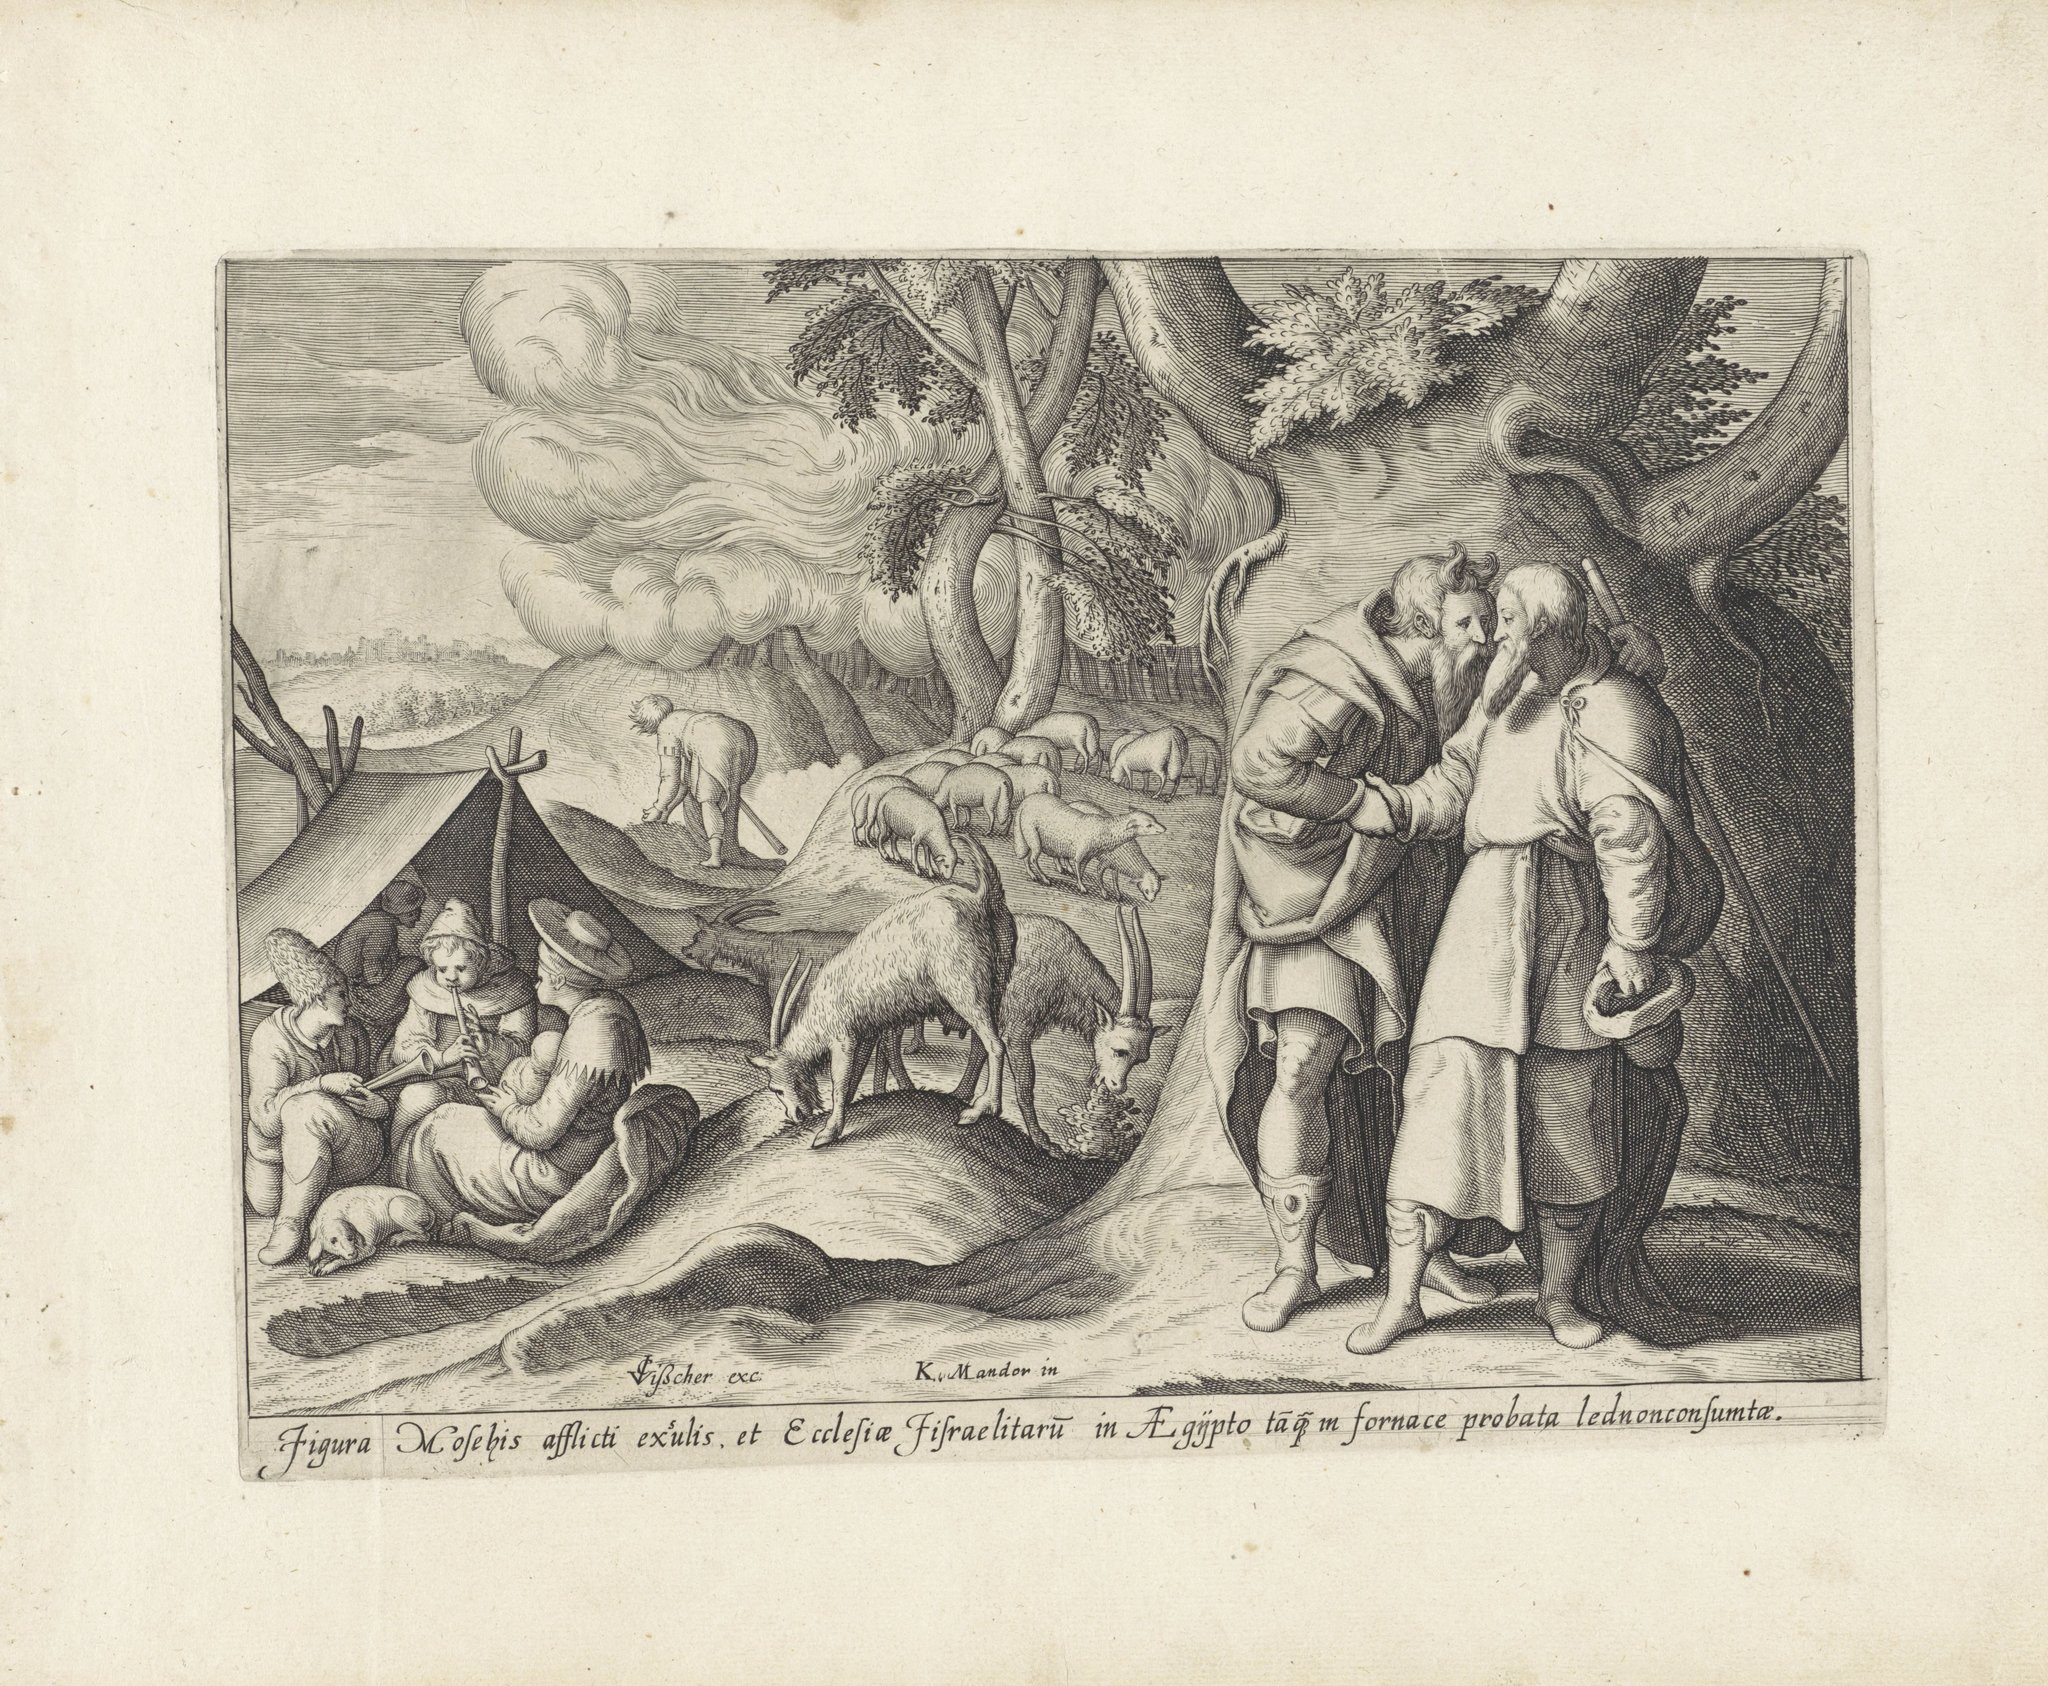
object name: print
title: Mozes bij de herders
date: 1601-1652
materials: paper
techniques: engraving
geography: low countries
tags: moses at a well meets the seven daughters of jethro, the priest of midian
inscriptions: collector's mark: Lugt 2228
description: Links musiceren enkele vrouwen, mogelijk de dochters van de Midjanitische priester Reüel. Achter hen een kudde geiten en schapen. Rechts staat Mozes bij een man, mogelijk Reüel die hem bedankt voor zijn hulp bij het drenken van de kudde.